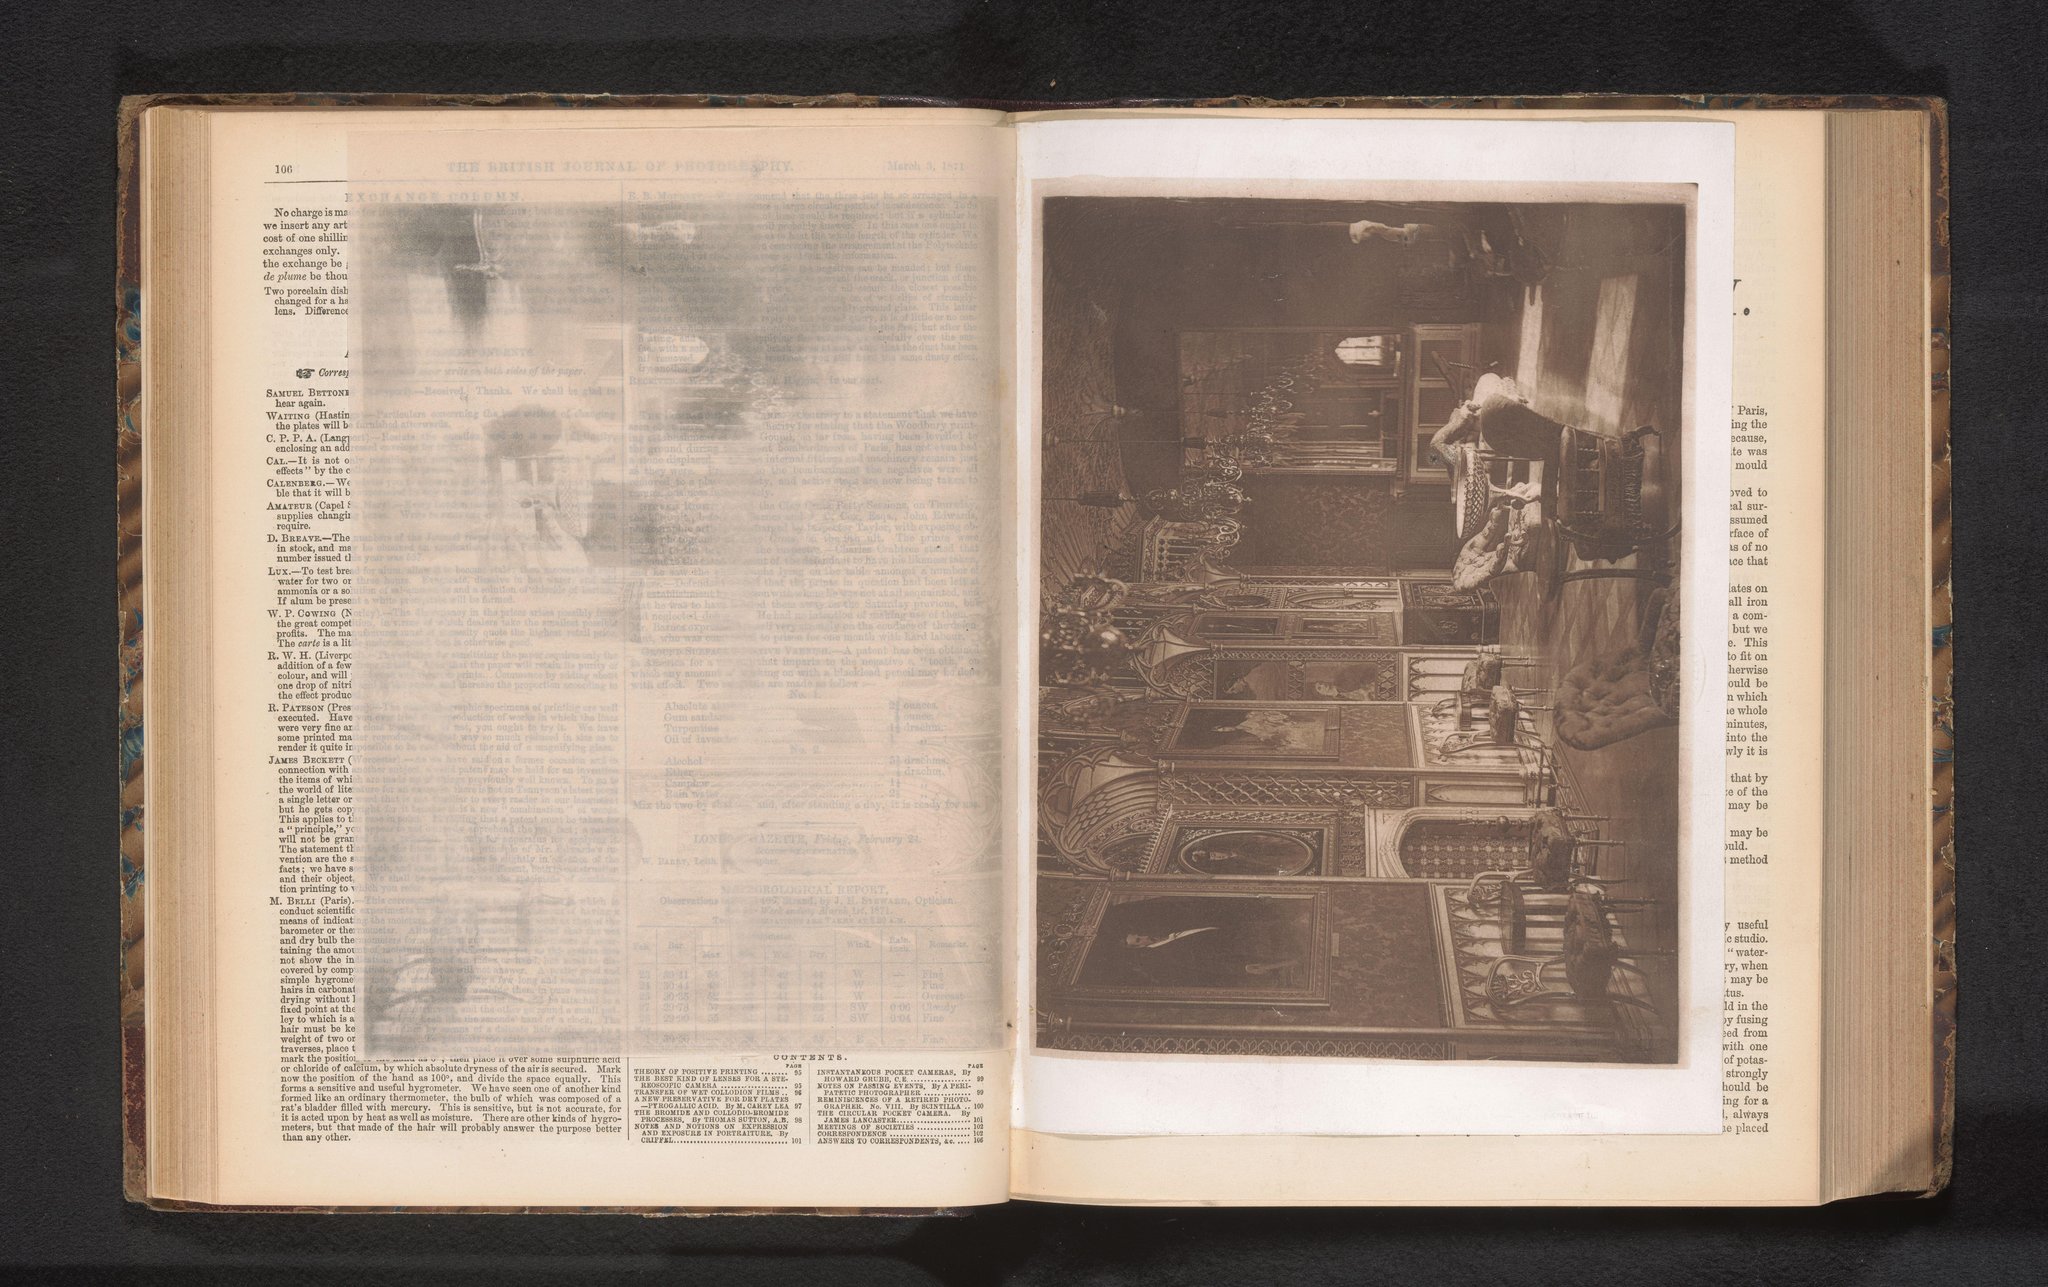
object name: photomechanical print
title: Interieur van de schilderijengalerij in Strawberry Hill te Londen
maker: ernest edwards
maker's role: fotograaf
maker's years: 1837-1903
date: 1869-1871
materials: paper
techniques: photograph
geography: strawberry hill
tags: art collection, art gallery